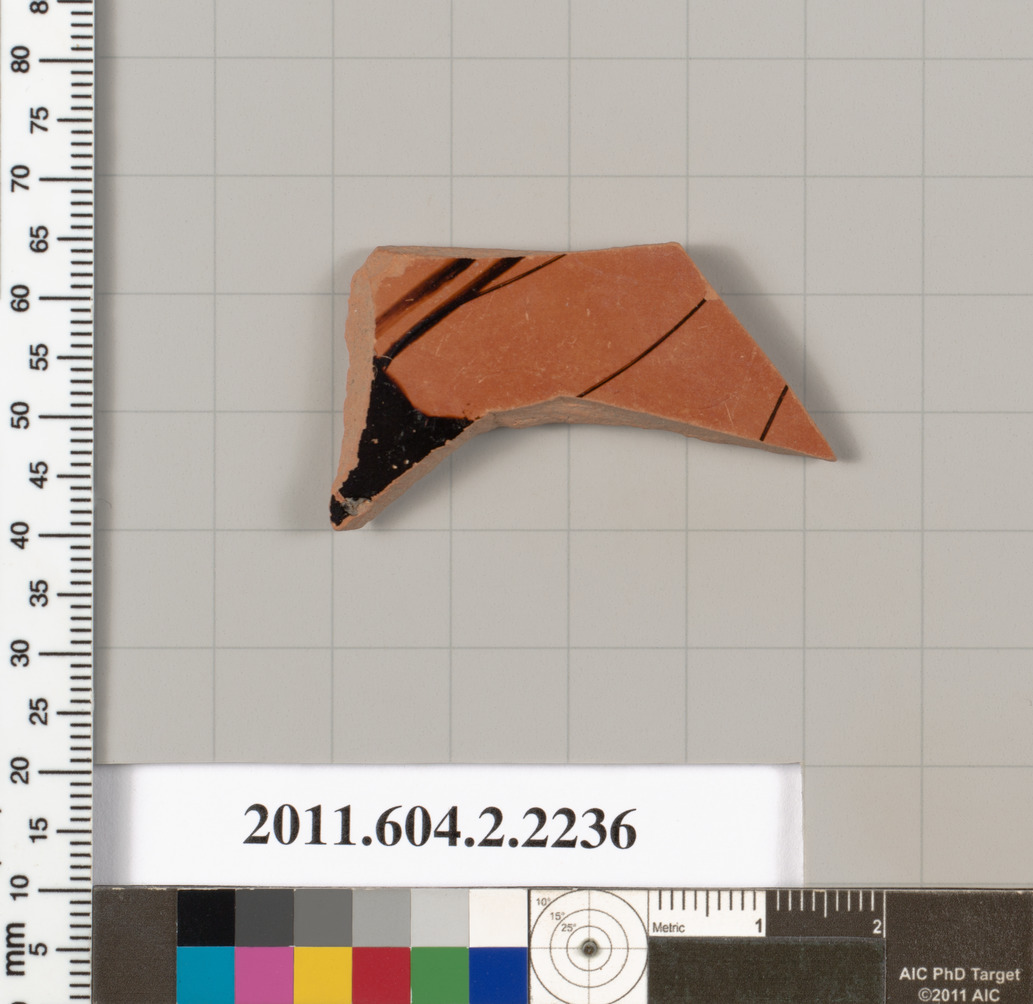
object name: pot fragment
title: Terracotta fragment of a pot; unglazed on the inside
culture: greek, attic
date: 460-440 BCE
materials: terracotta